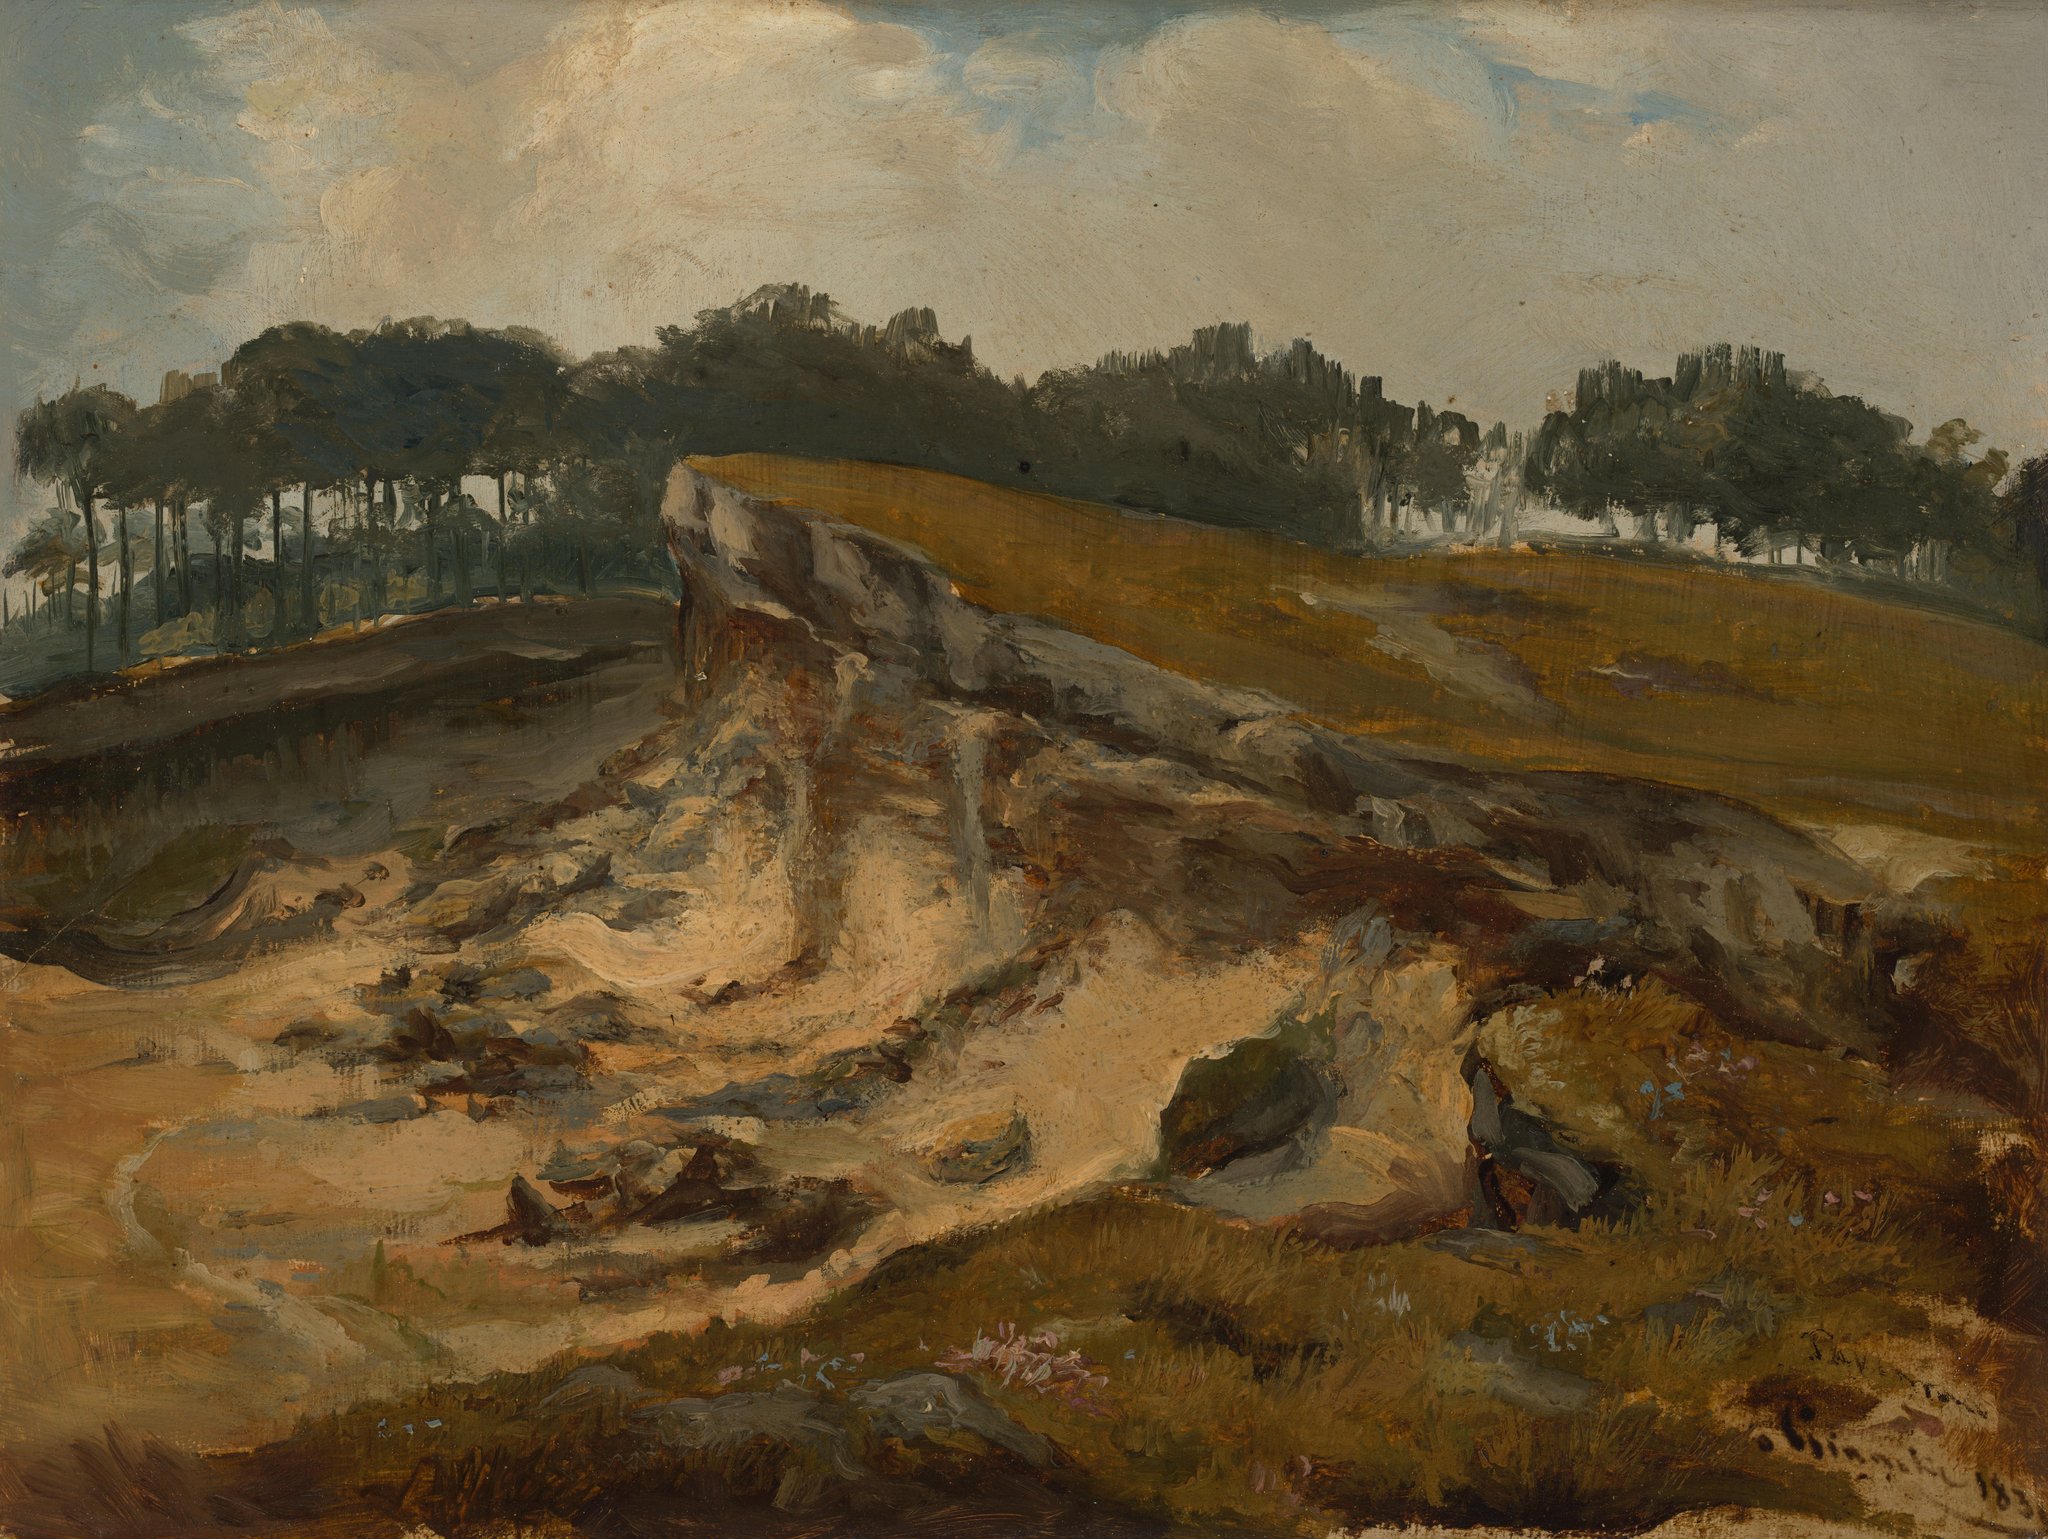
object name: painting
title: Sand Excavation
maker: johannes tavenraat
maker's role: draughtsman, painter, print maker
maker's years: 1809-1881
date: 1839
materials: board, oil, paper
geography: netherlands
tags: opencast mine; strip mining, sand (soil type)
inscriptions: signature and date: ‘Tavenraat Ginneke 1839’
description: Een heidelandschap met een zandafgraving in de omgeveing van Ginneken, in de verte een rij bomen.